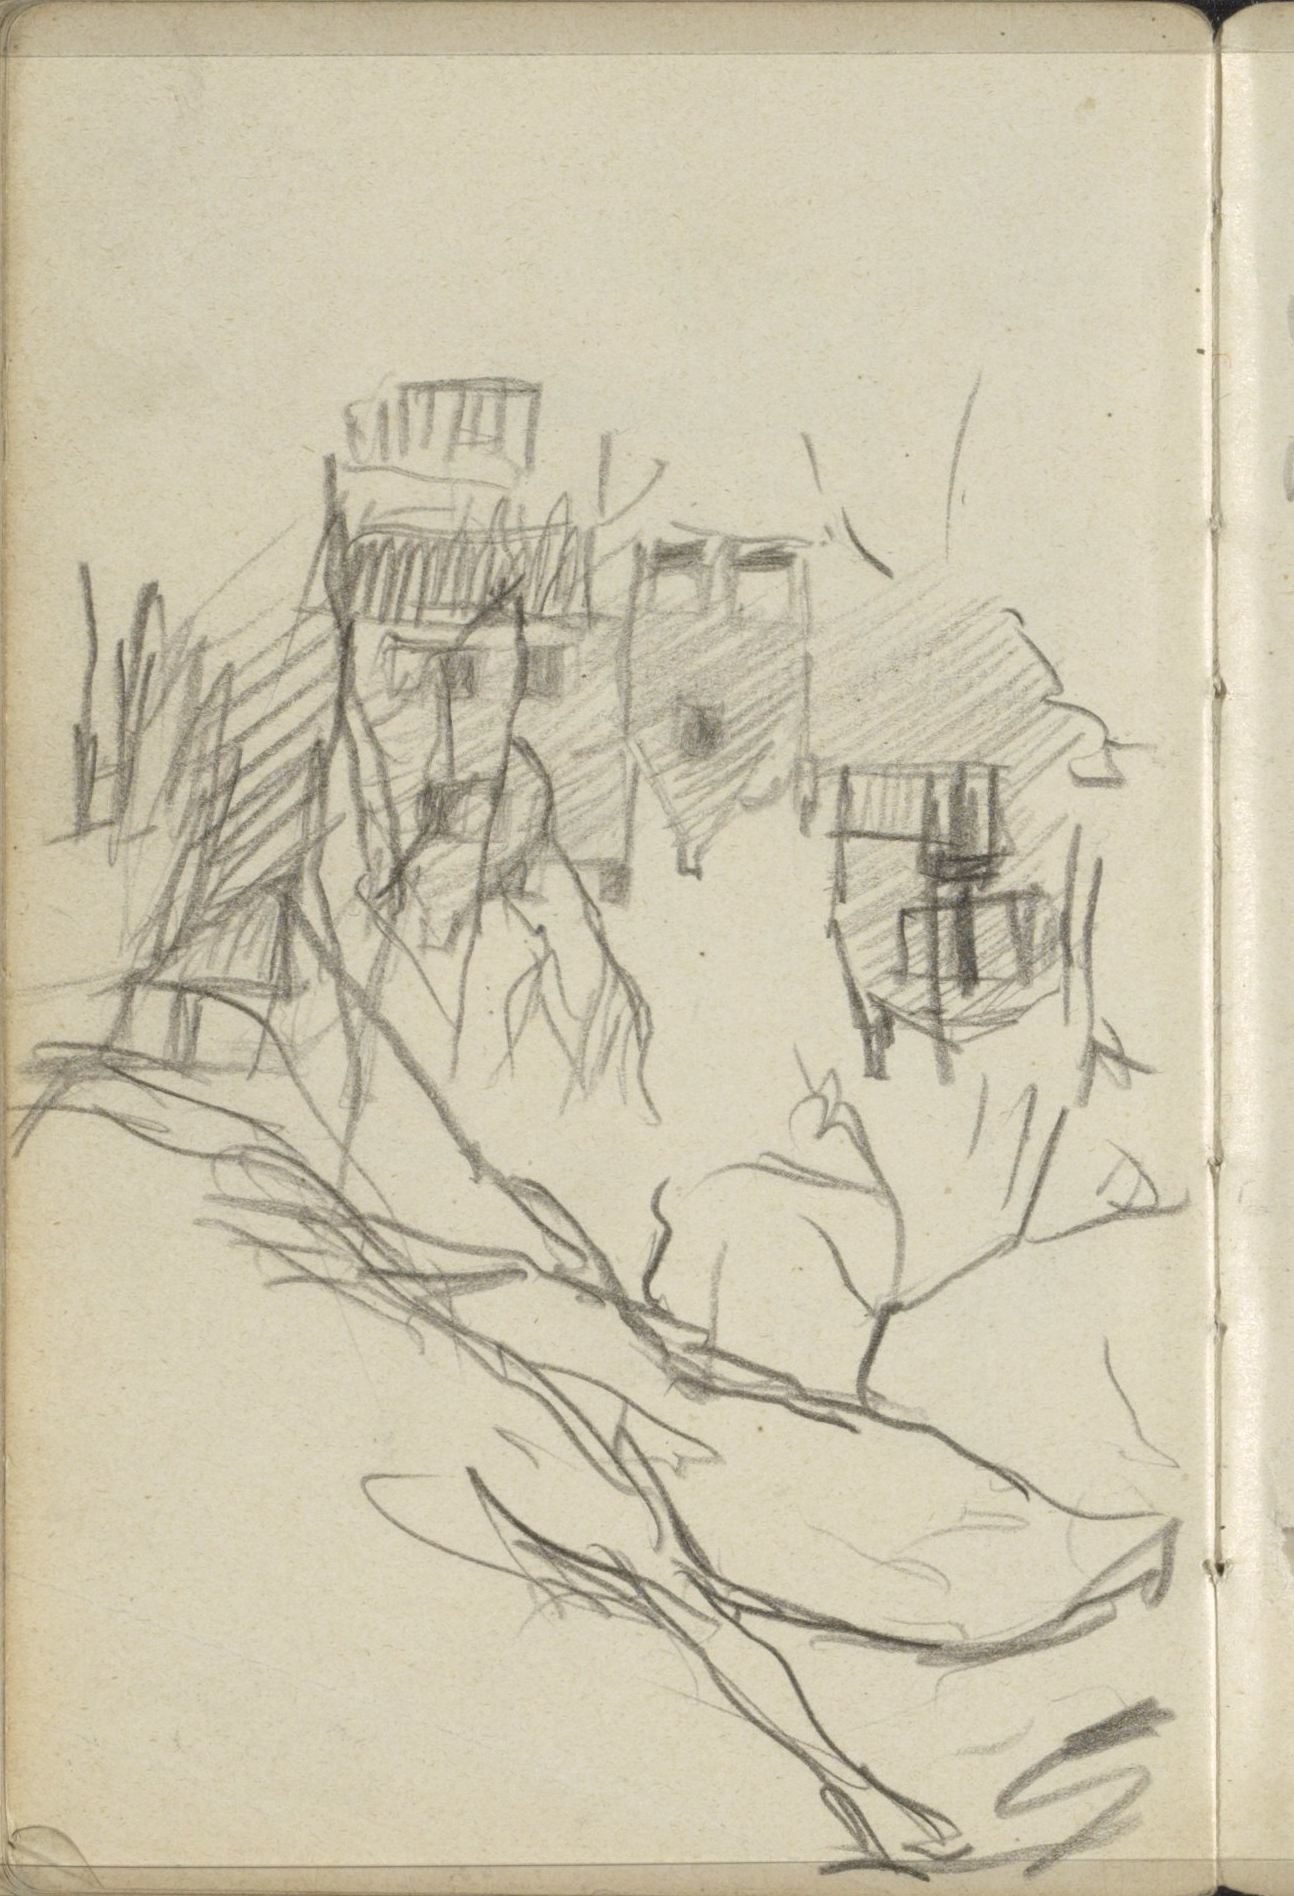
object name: sketchbook leaf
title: Gezicht in Amsterdam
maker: george hendrik breitner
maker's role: draughtsman, painter, print maker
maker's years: 1857-1923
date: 1910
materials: chalk, paper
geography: amsterdam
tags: trees, civic architecture; edifices; dwellings, street, amsterdam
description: Pagina 87 uit een schetsboek met 45 bladen.